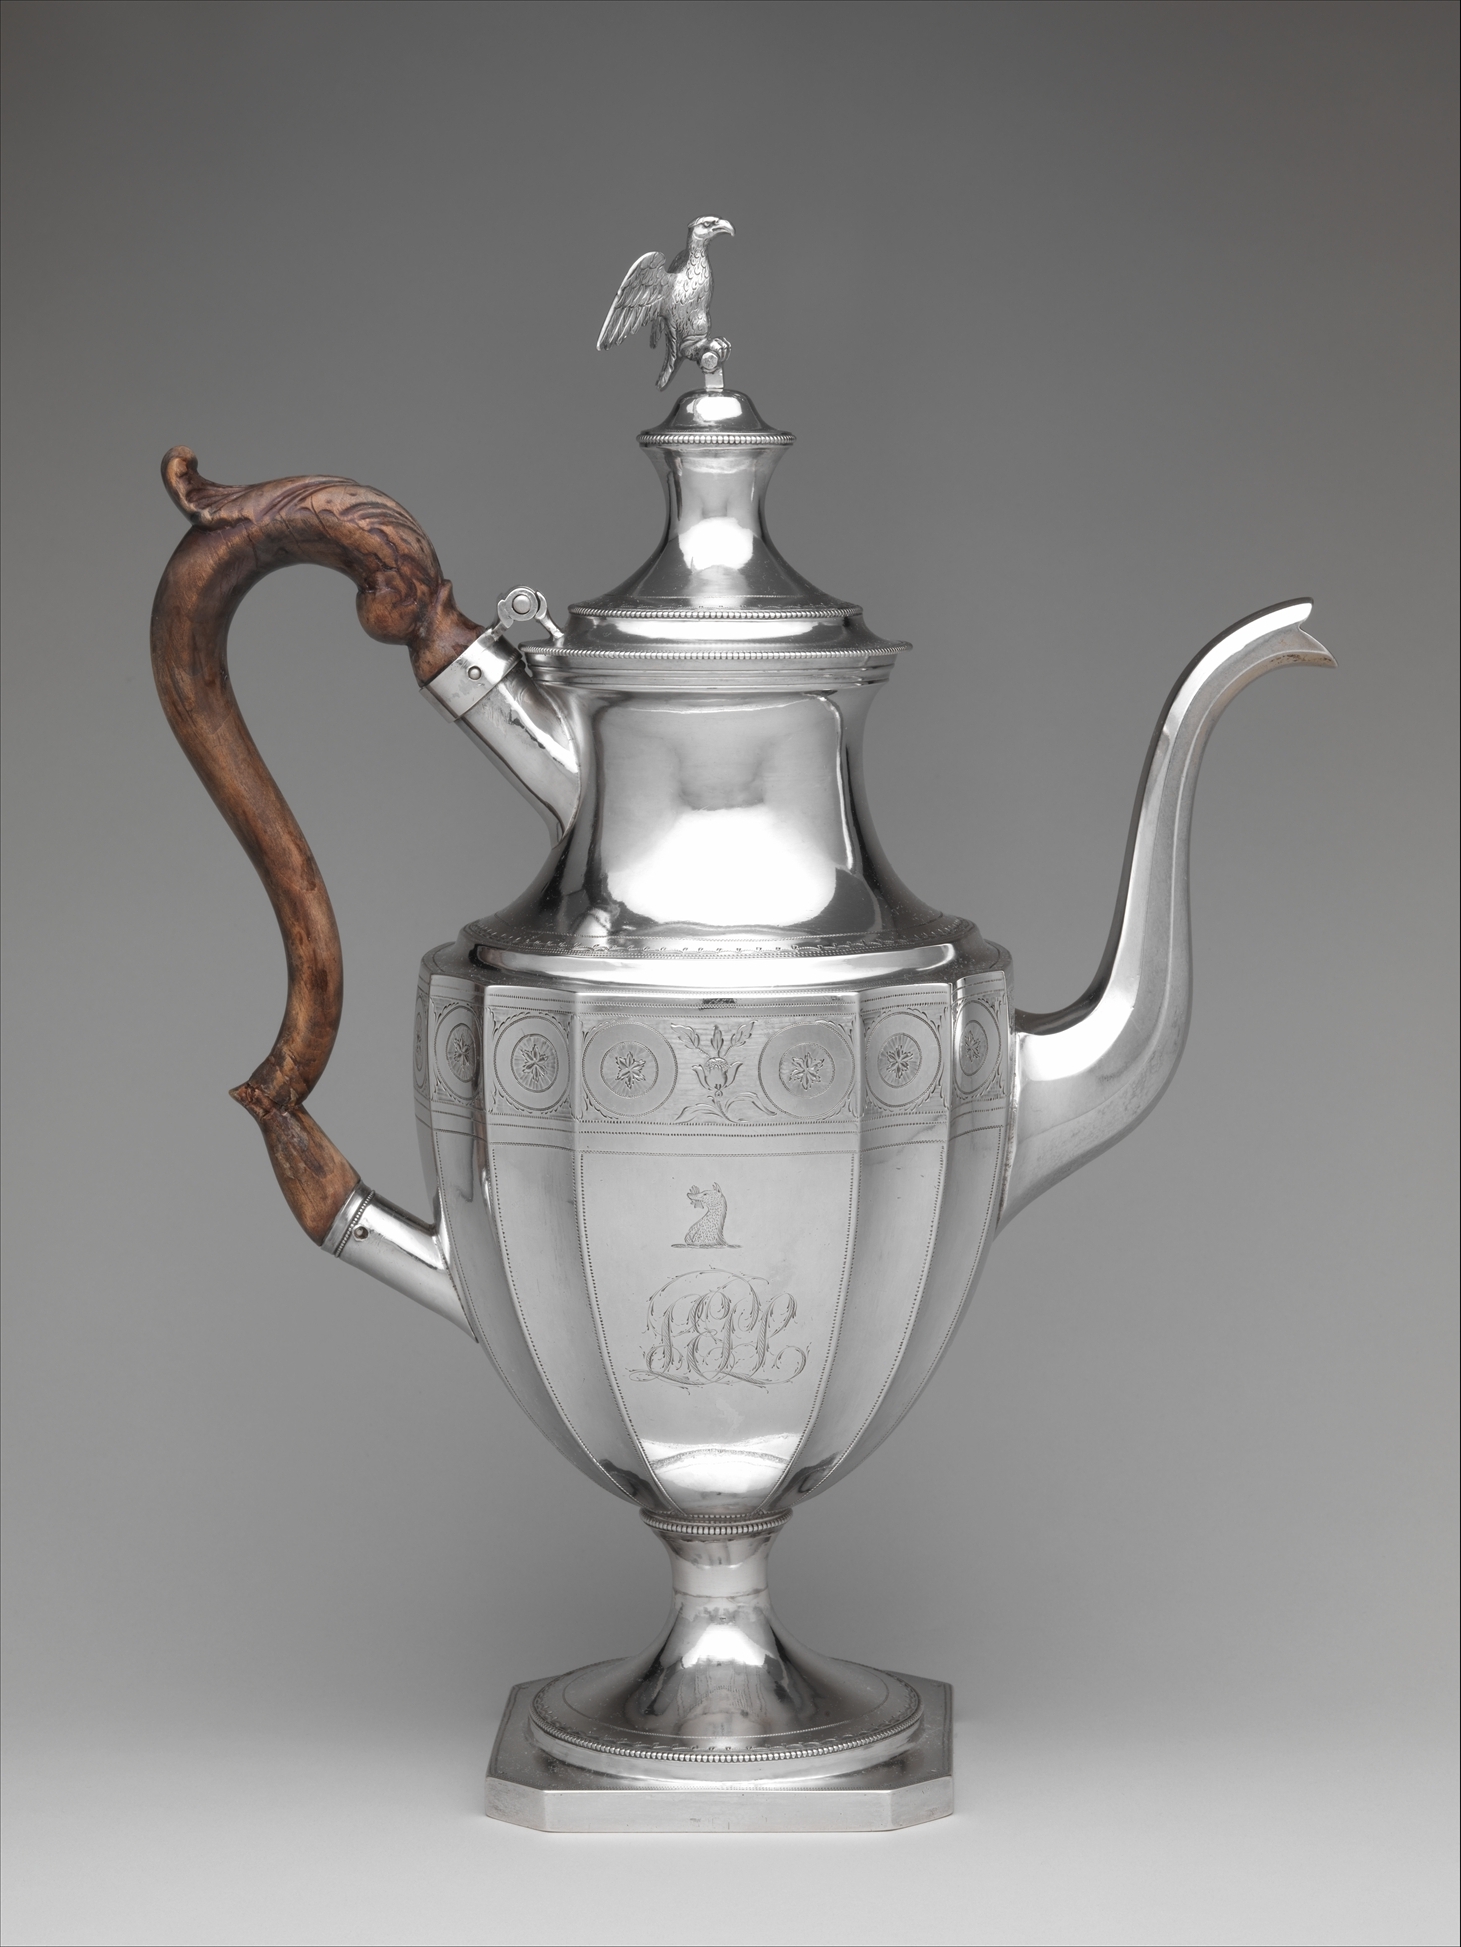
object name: coffeepot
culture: american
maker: christian wiltberger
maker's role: maker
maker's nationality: american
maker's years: 1766-1851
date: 1800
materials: silver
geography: united states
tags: eagles